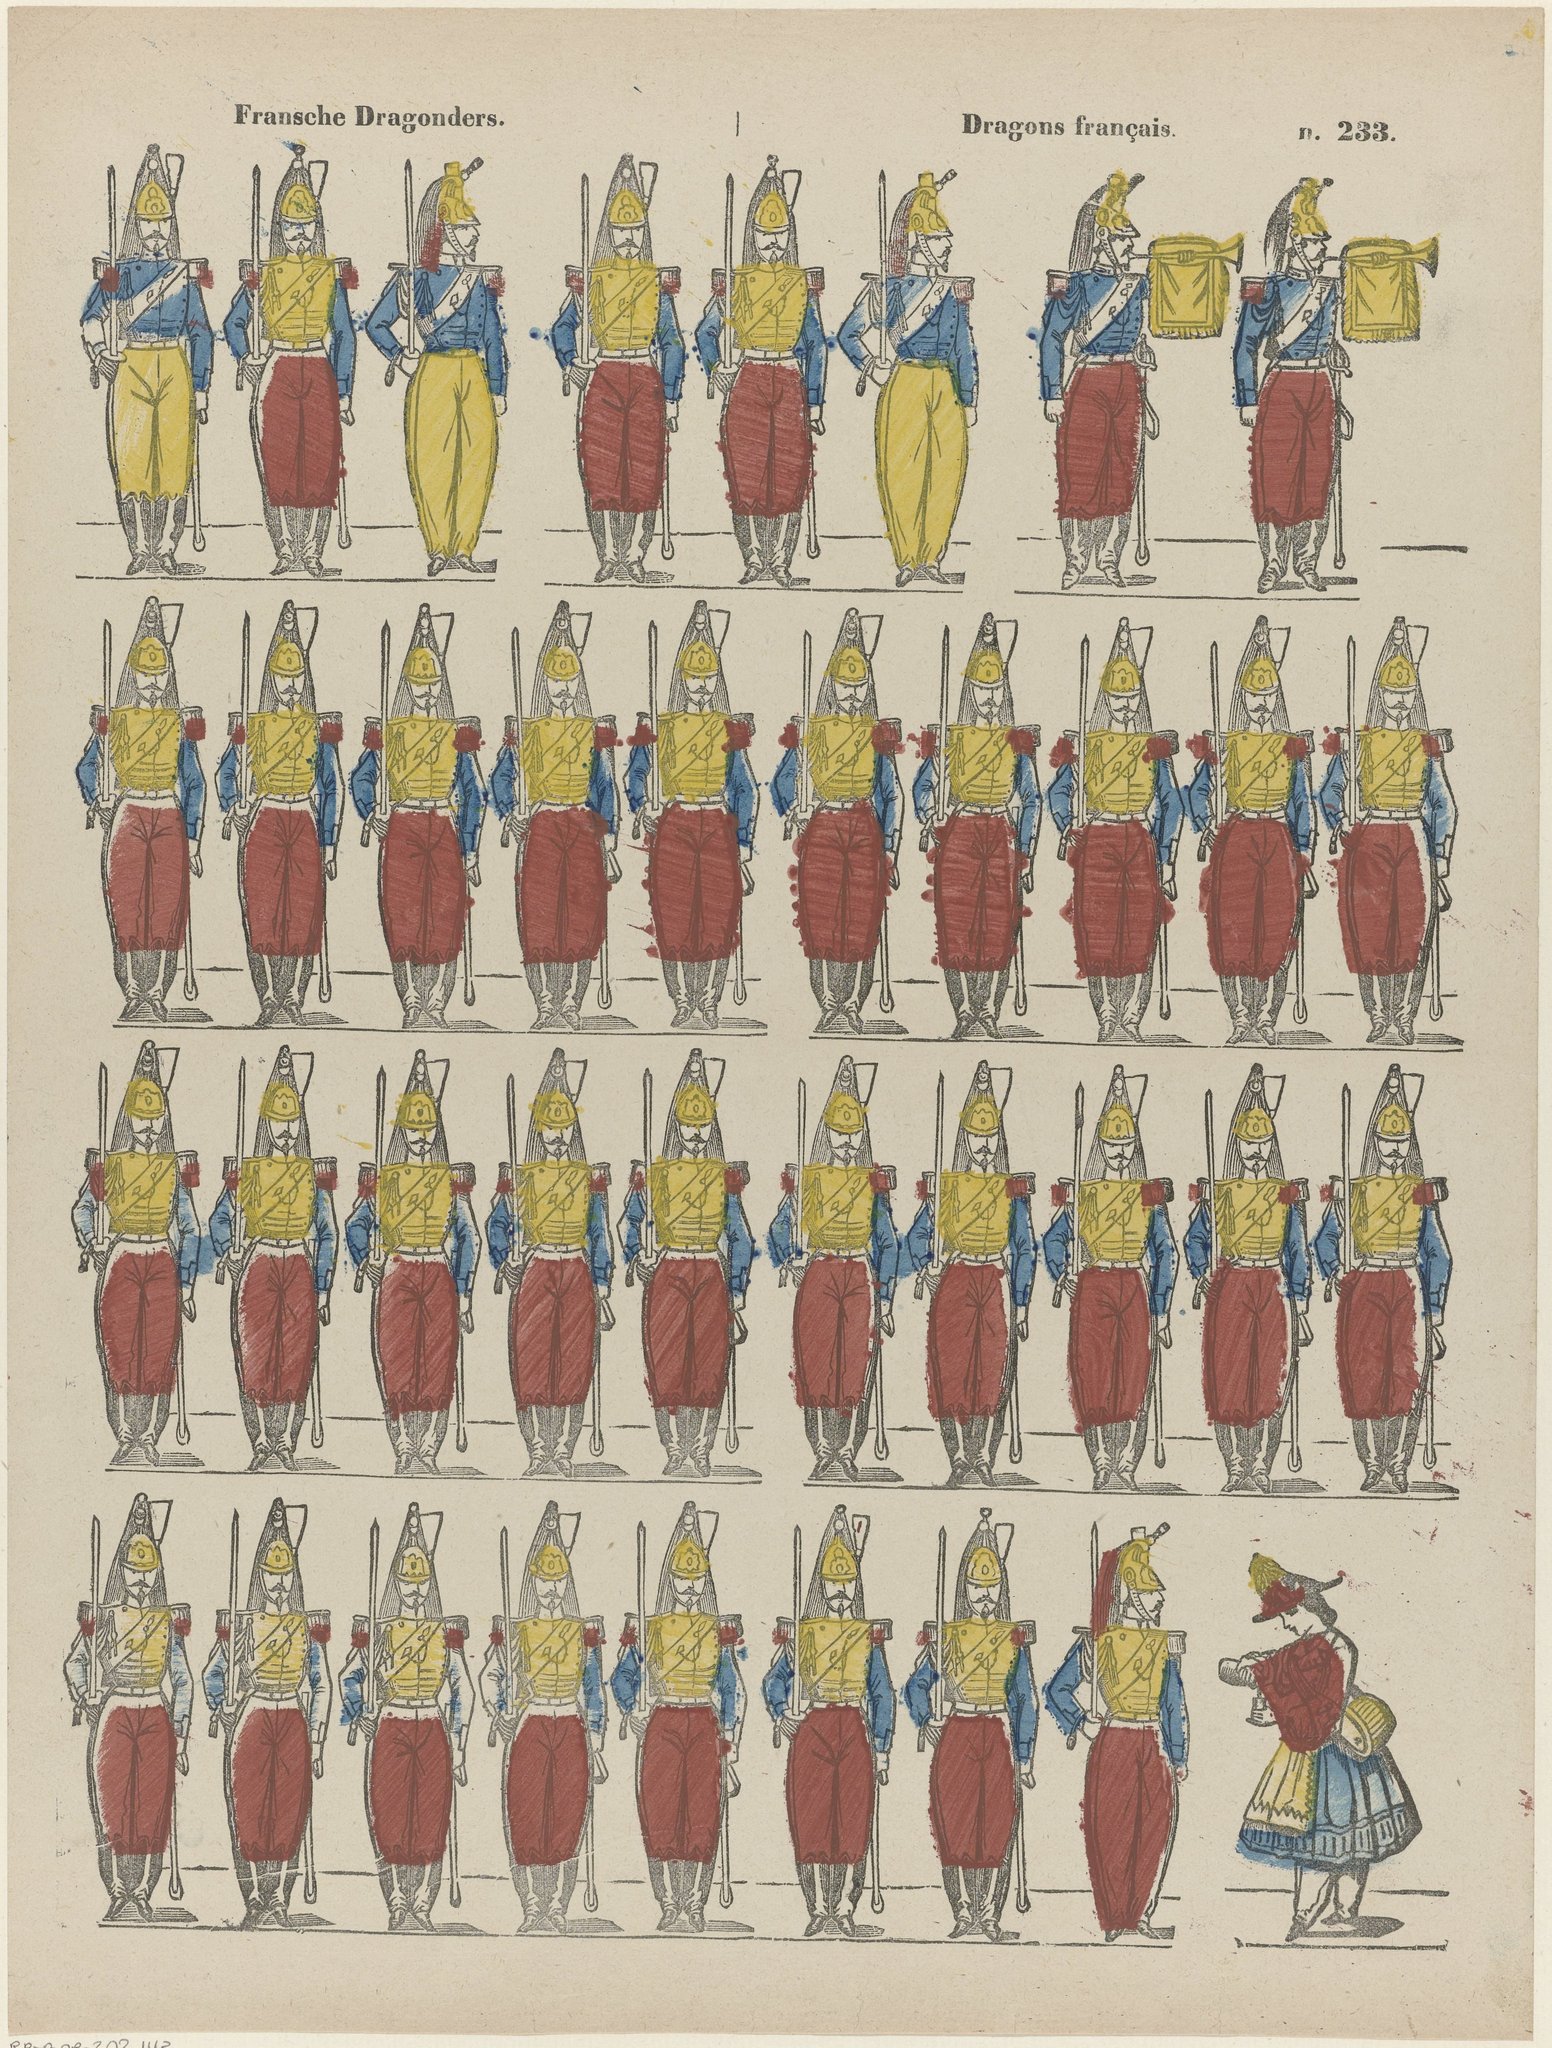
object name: popular print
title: Fransche dragonders / Dragons français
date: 1800-1833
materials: paper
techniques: colour, letterpress printing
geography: turnhout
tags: the soldier; the soldier's life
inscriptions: collector's mark: Lugt 2760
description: Blad met 4 horizontale rijen met in totaal 37 voorstellingen van Franse militairen. Genummerd rechtsboven: n. 233.